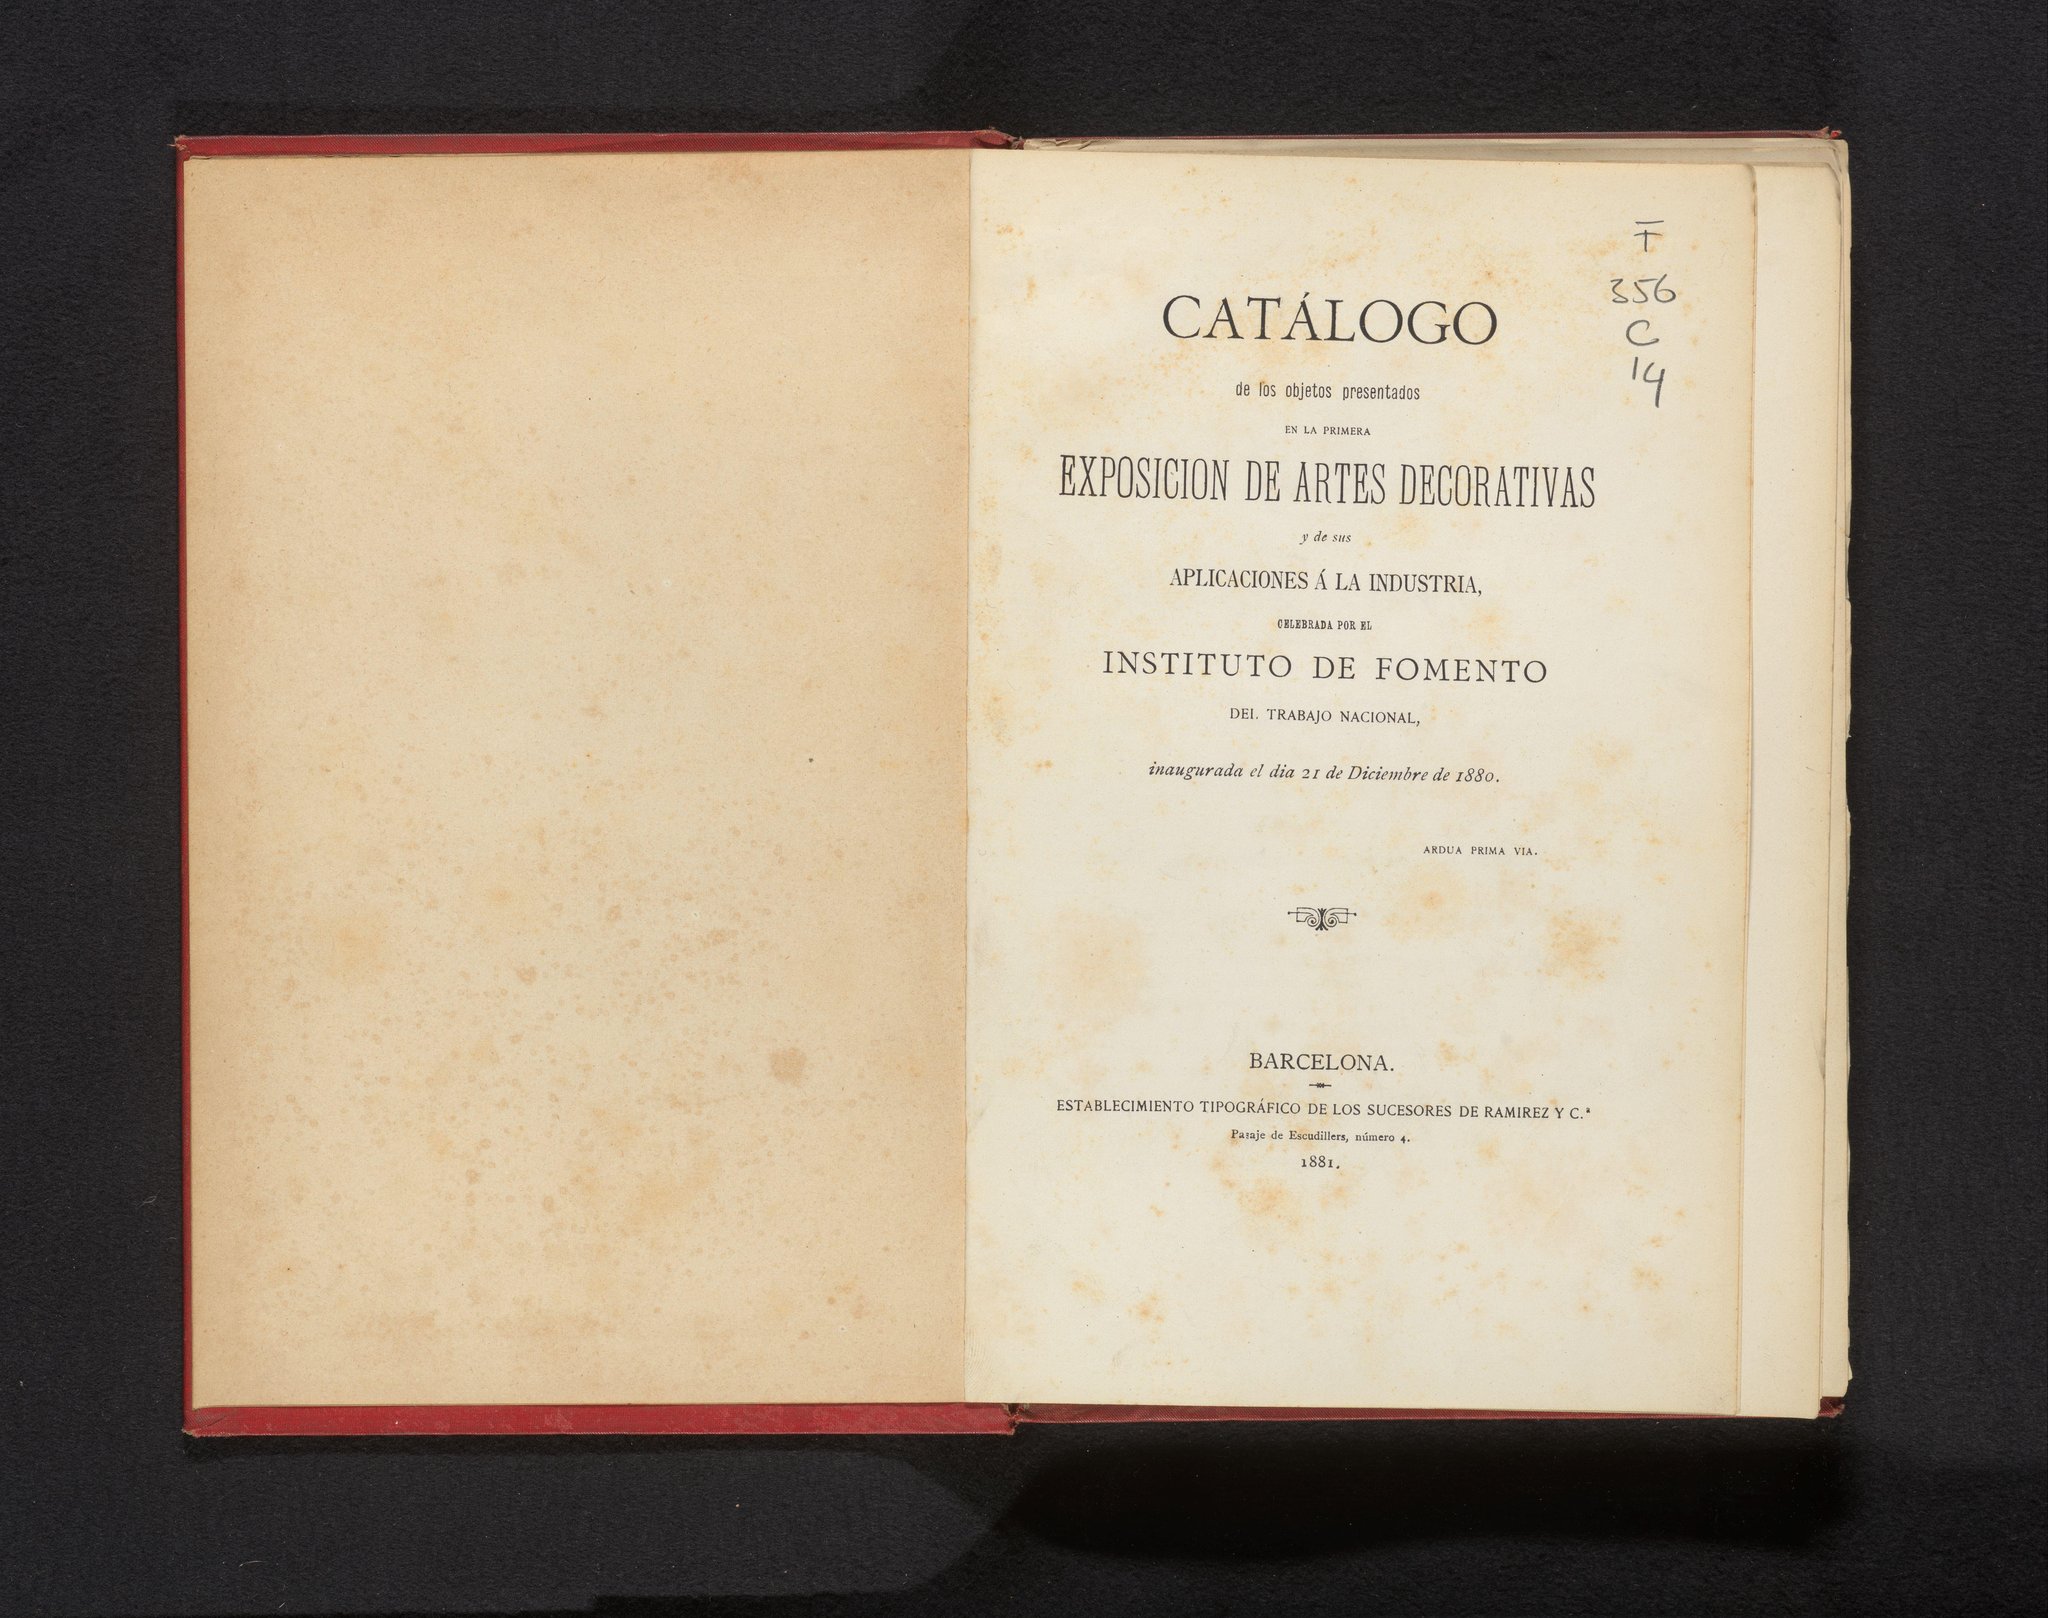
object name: book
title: Catálogo de los objetos presentados en la primera exposicion de artes decorativas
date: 1881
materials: cardboard, linen, paper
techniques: photograph, printing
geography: barcelona